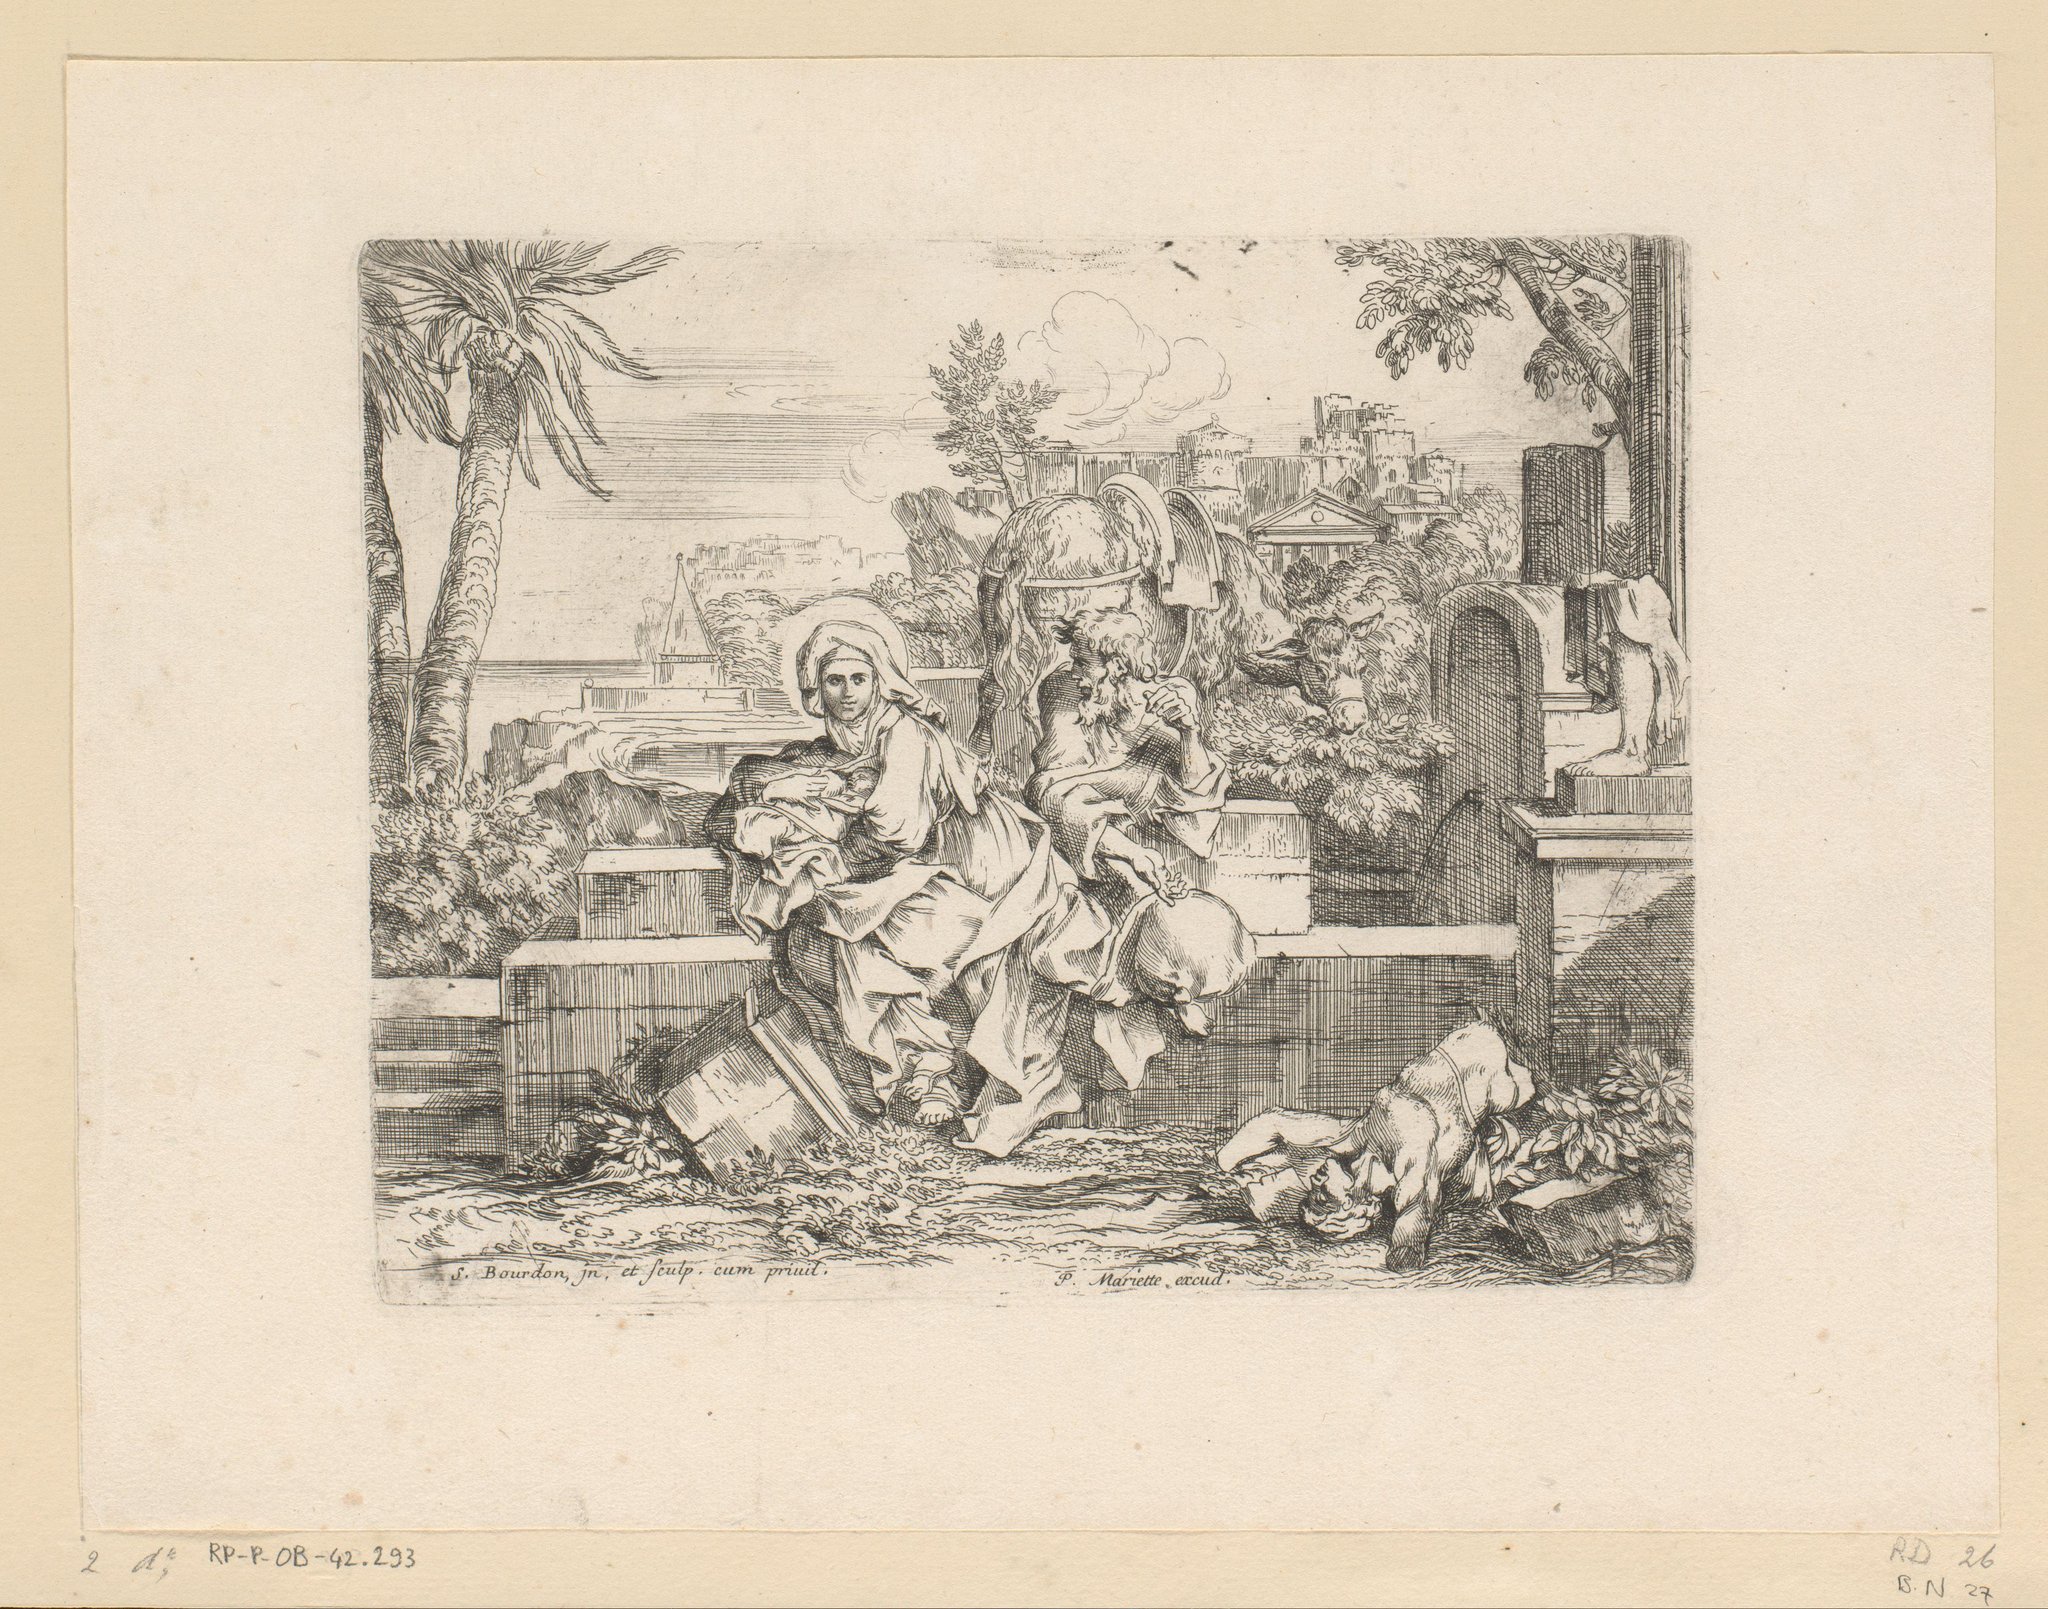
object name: print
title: Taferelen uit de vlucht naar Egypte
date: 1626-1657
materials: paper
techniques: etching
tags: rest on the flight into egypt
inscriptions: collector's mark: Lugt 240